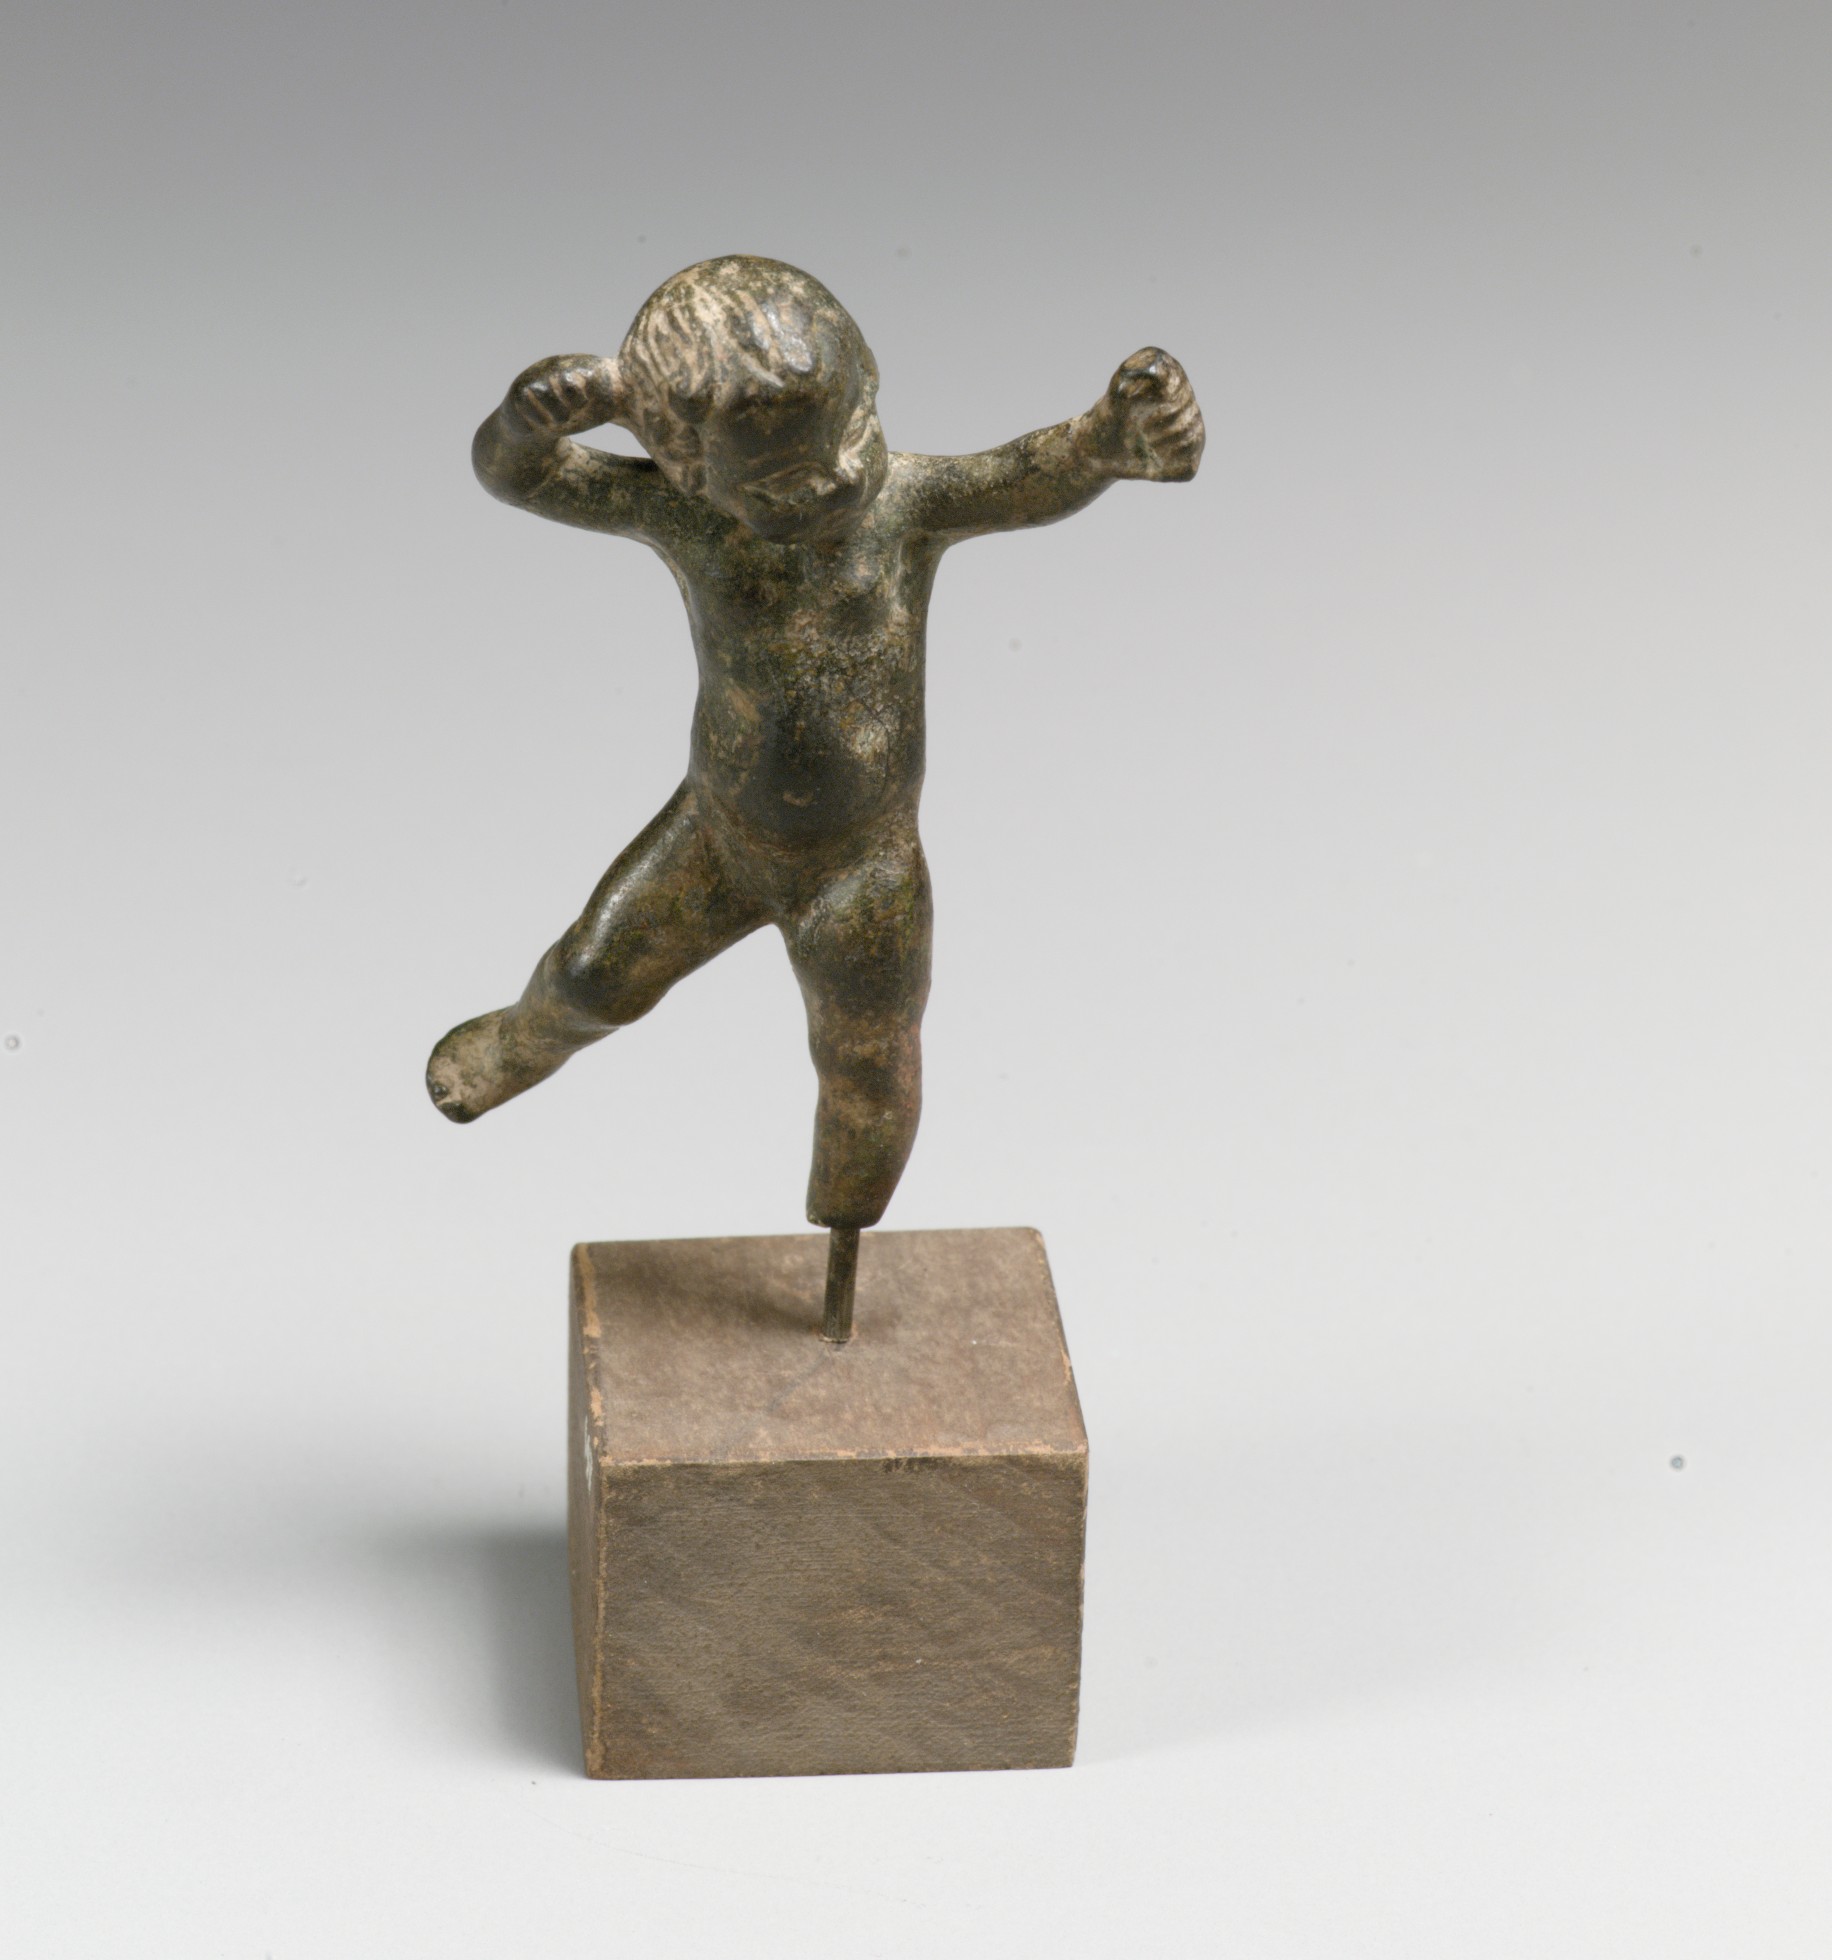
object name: statuette of cupid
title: Bronze statuette of Cupid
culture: roman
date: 1-200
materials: bronze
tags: cupid